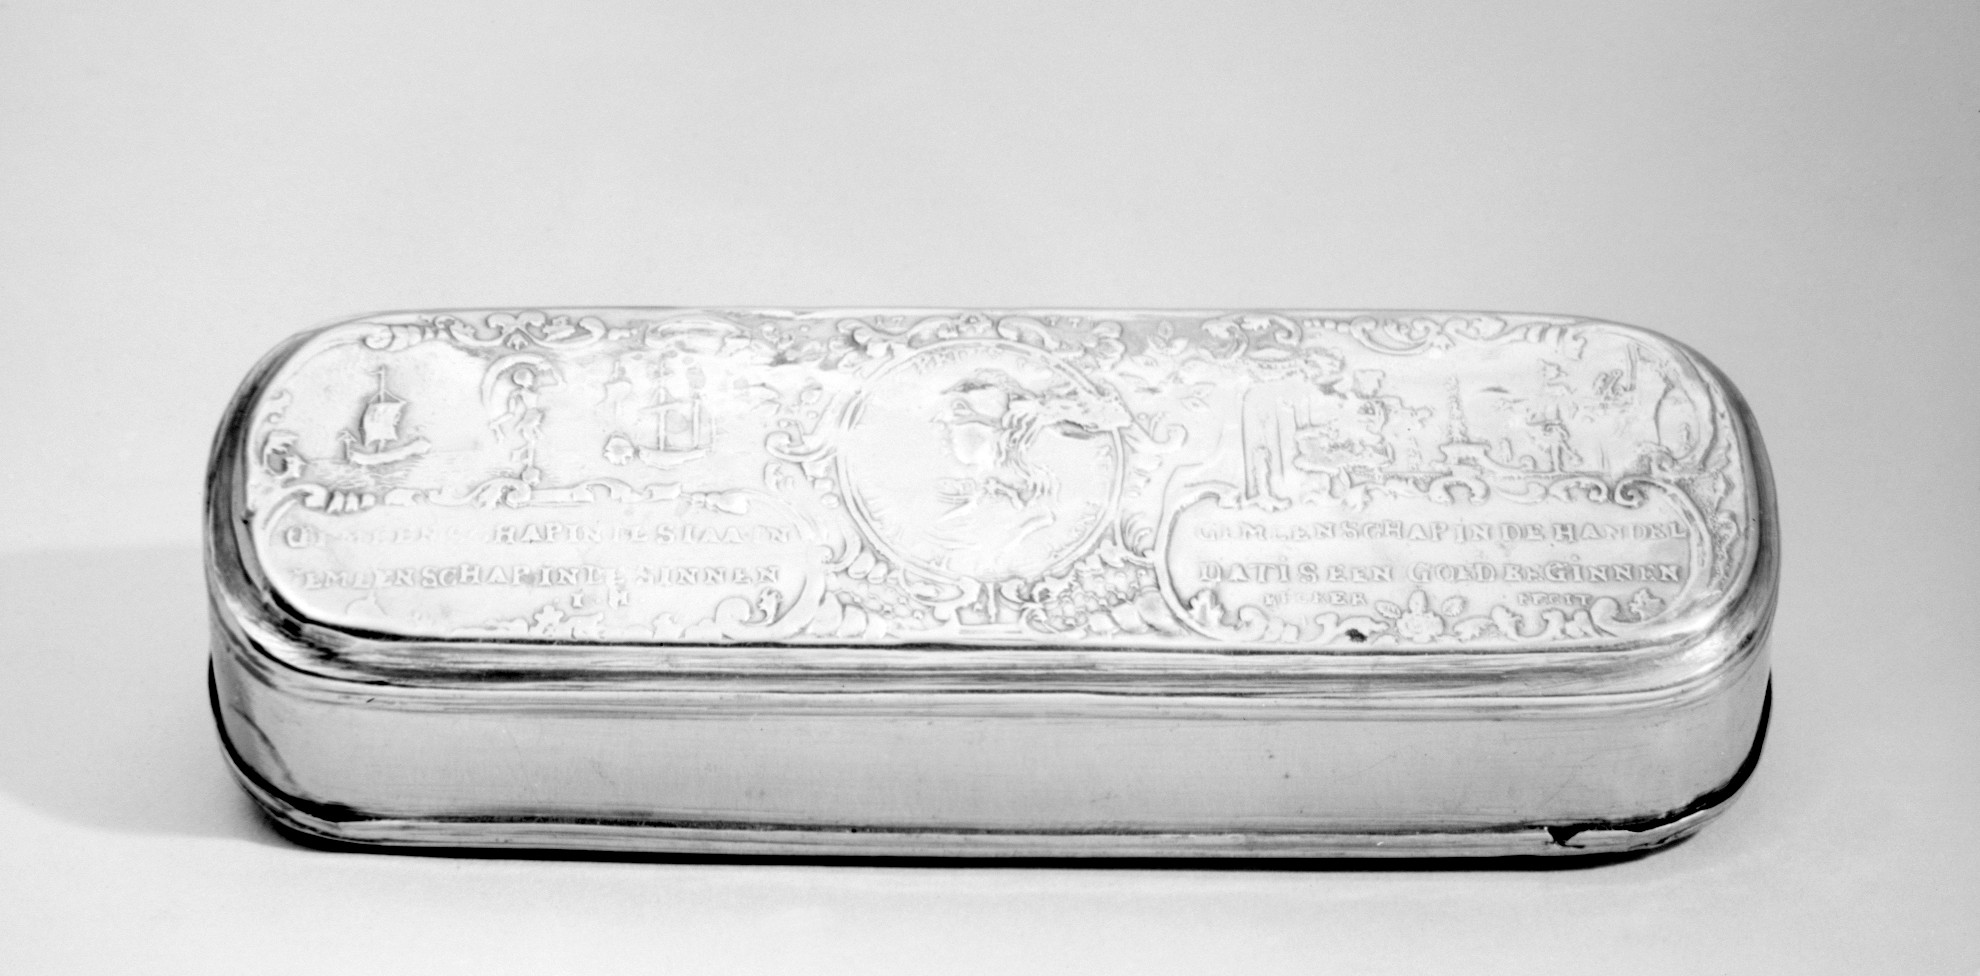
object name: tobacco box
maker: i. h. becker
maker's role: maker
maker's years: 1725-1825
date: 1777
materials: brass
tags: human figures